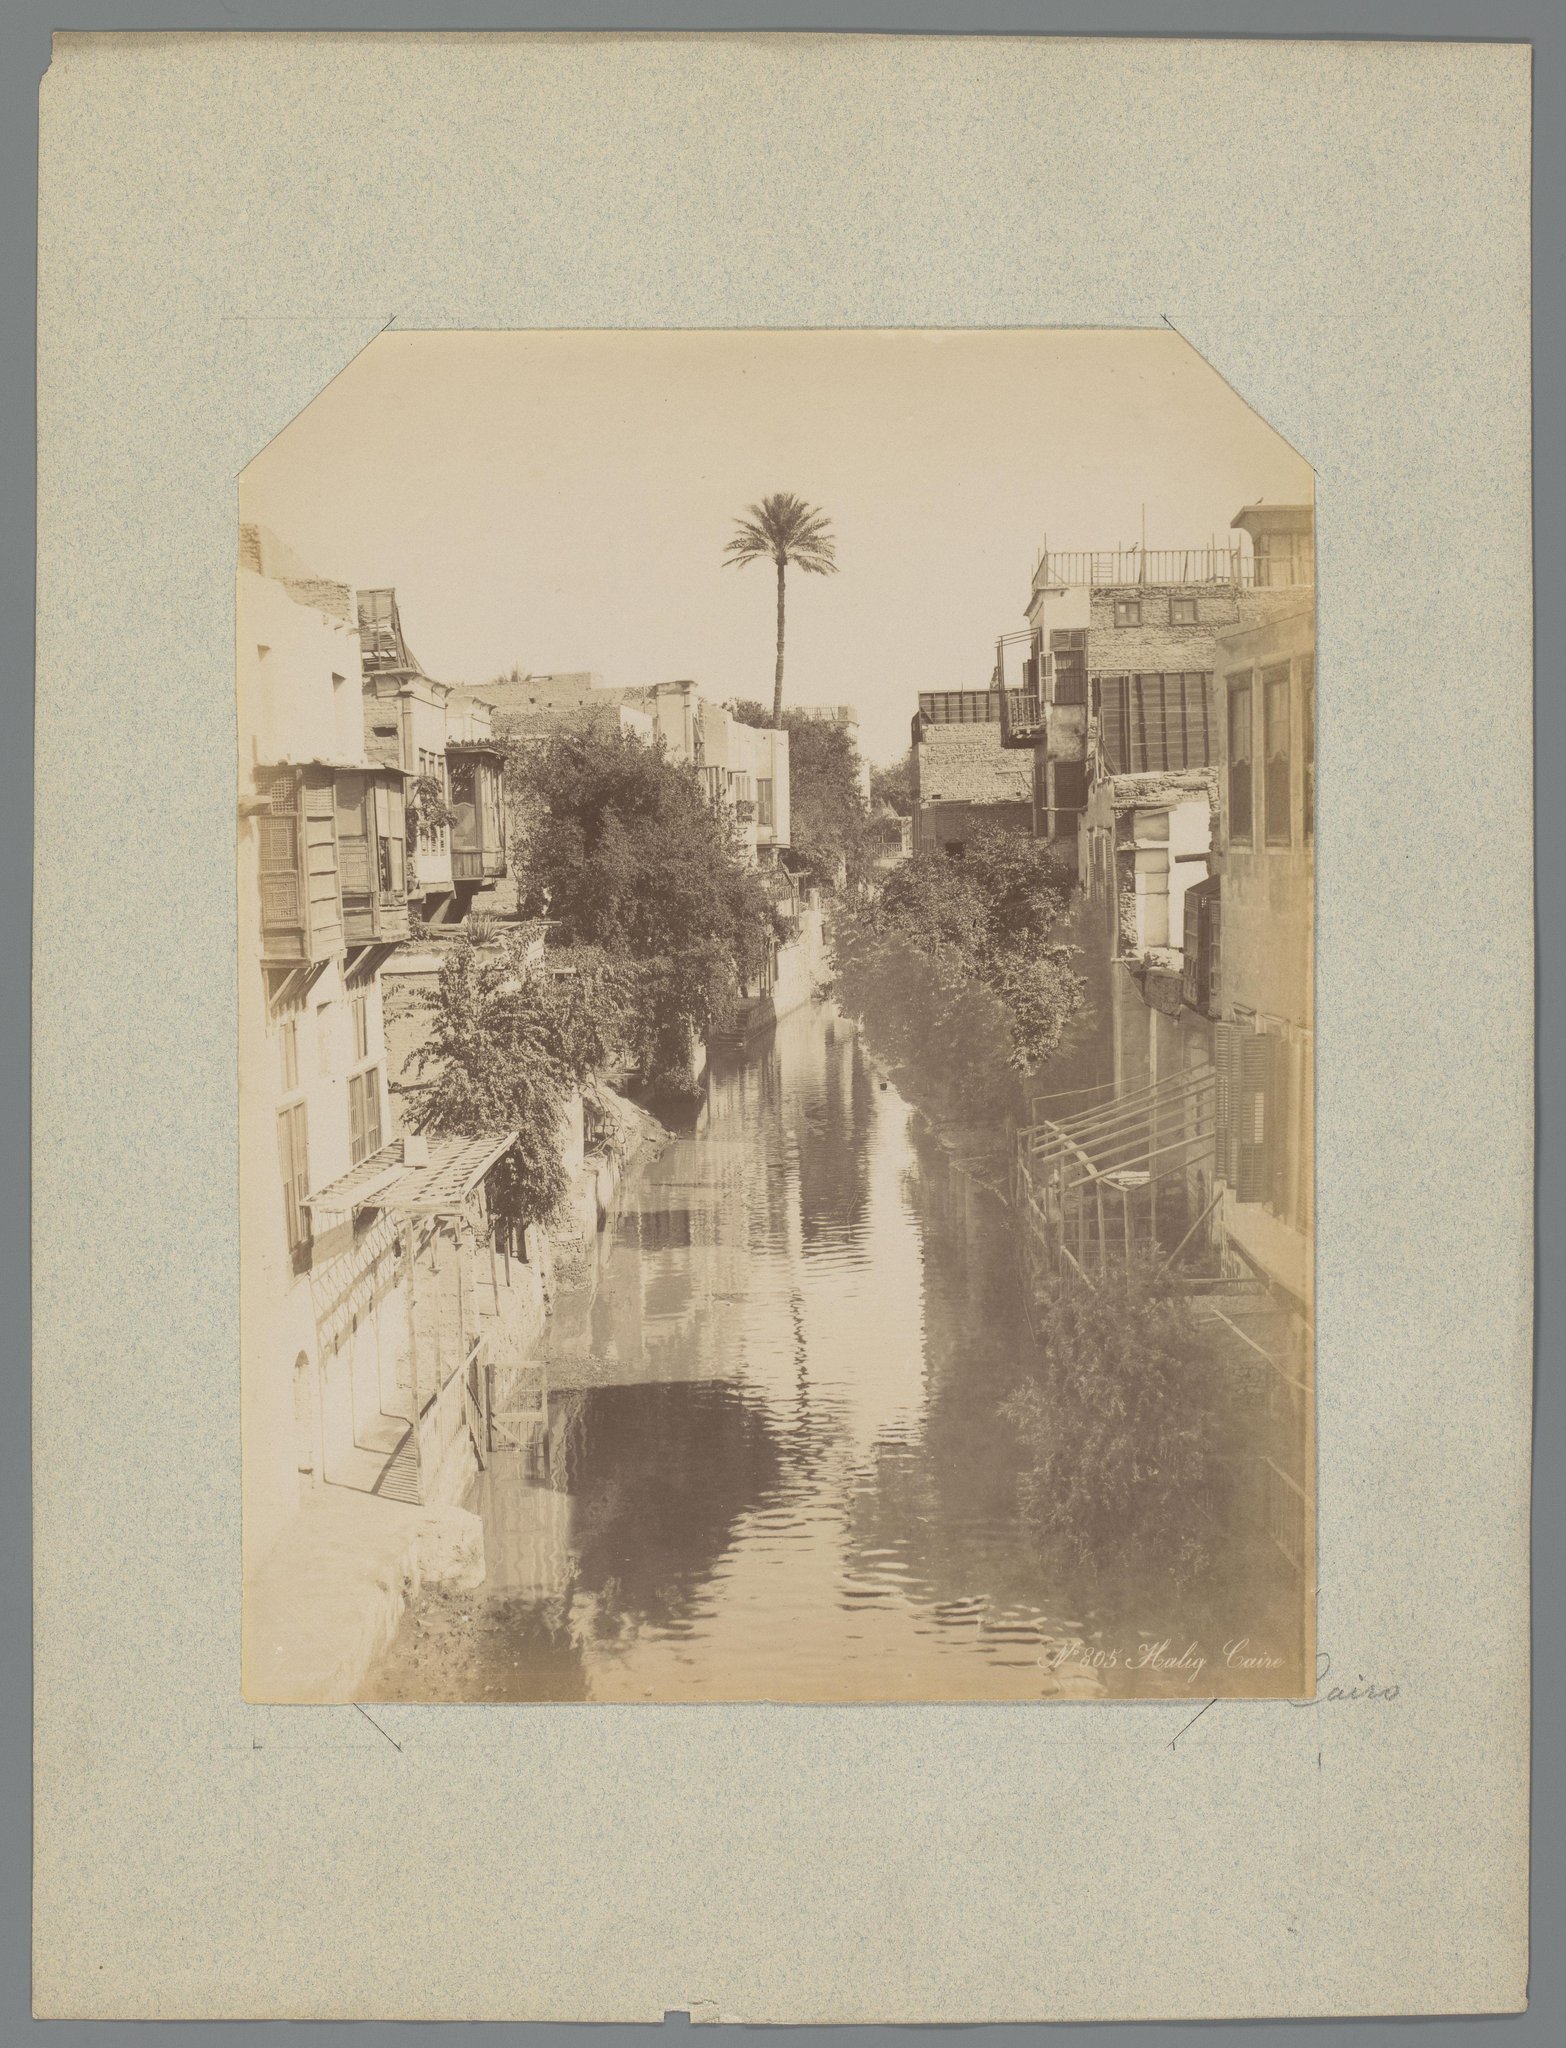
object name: photograph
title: Halig Caire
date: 1870-1910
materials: cardboard, paper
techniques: albumen print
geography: cairo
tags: canals, waters (in city)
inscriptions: number: ‘No 805’